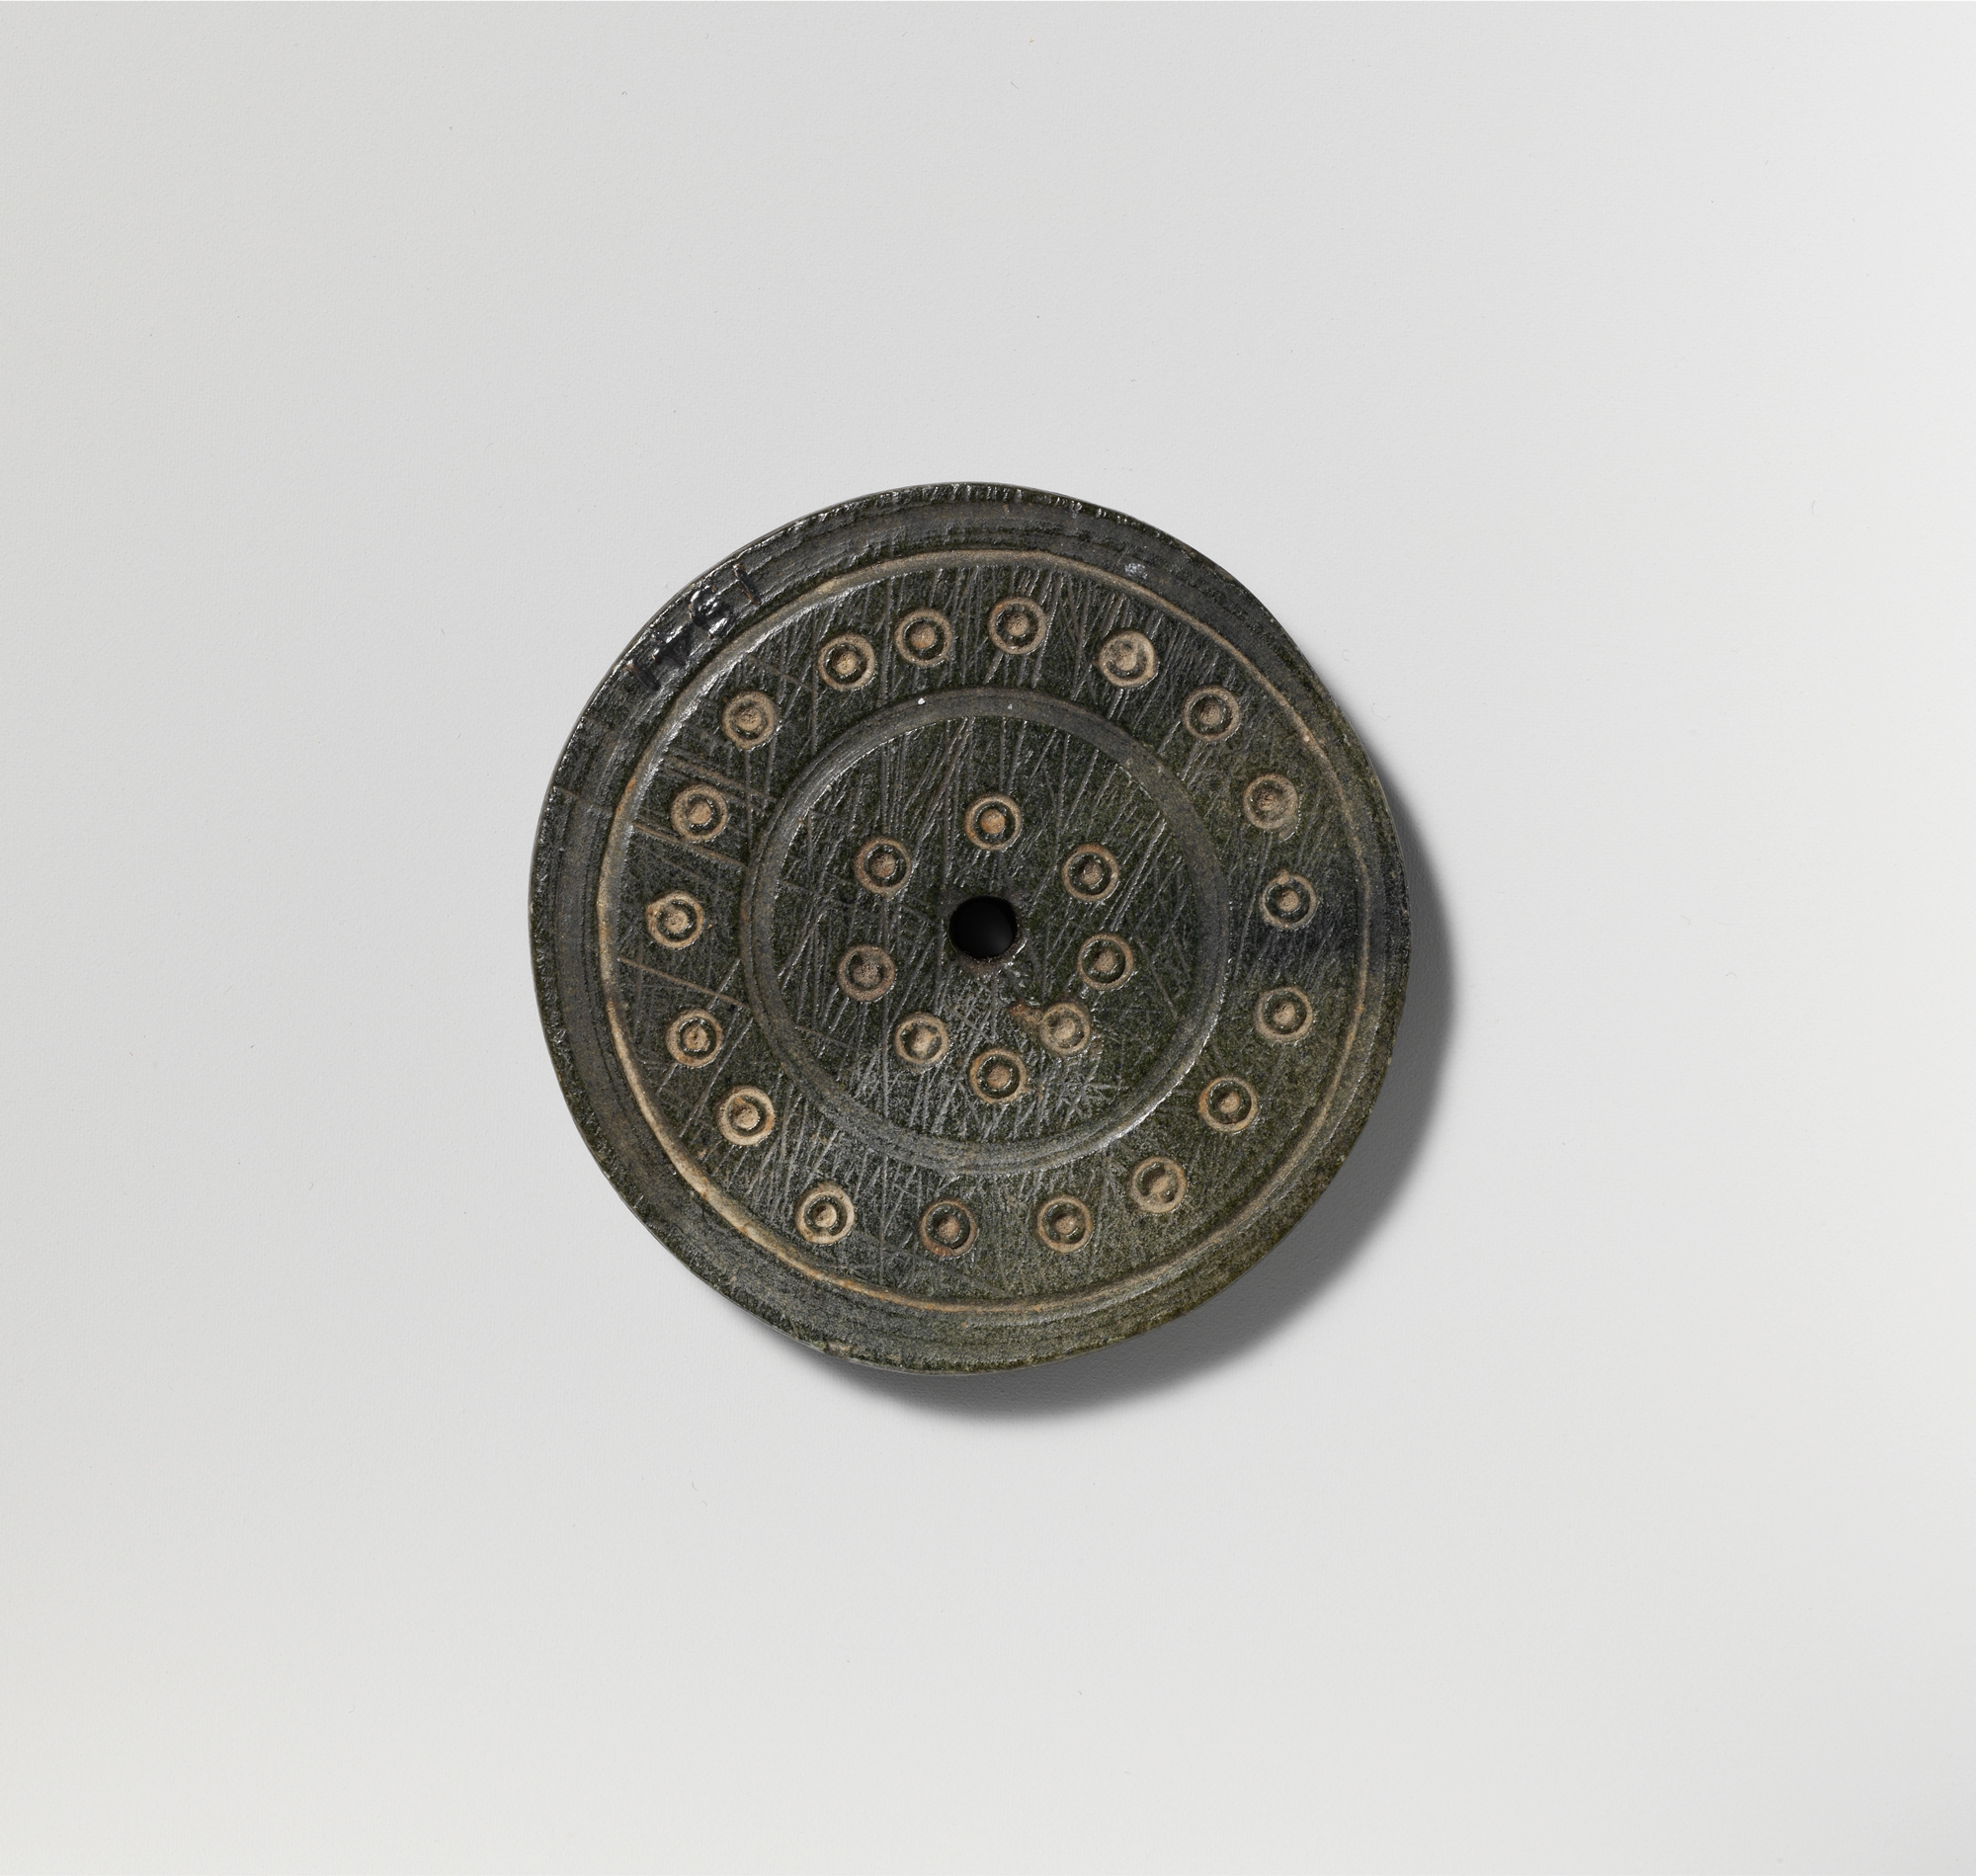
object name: vase with lid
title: Chlorite lid of a vase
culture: cypriot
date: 1200-1100 BCE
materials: mineral